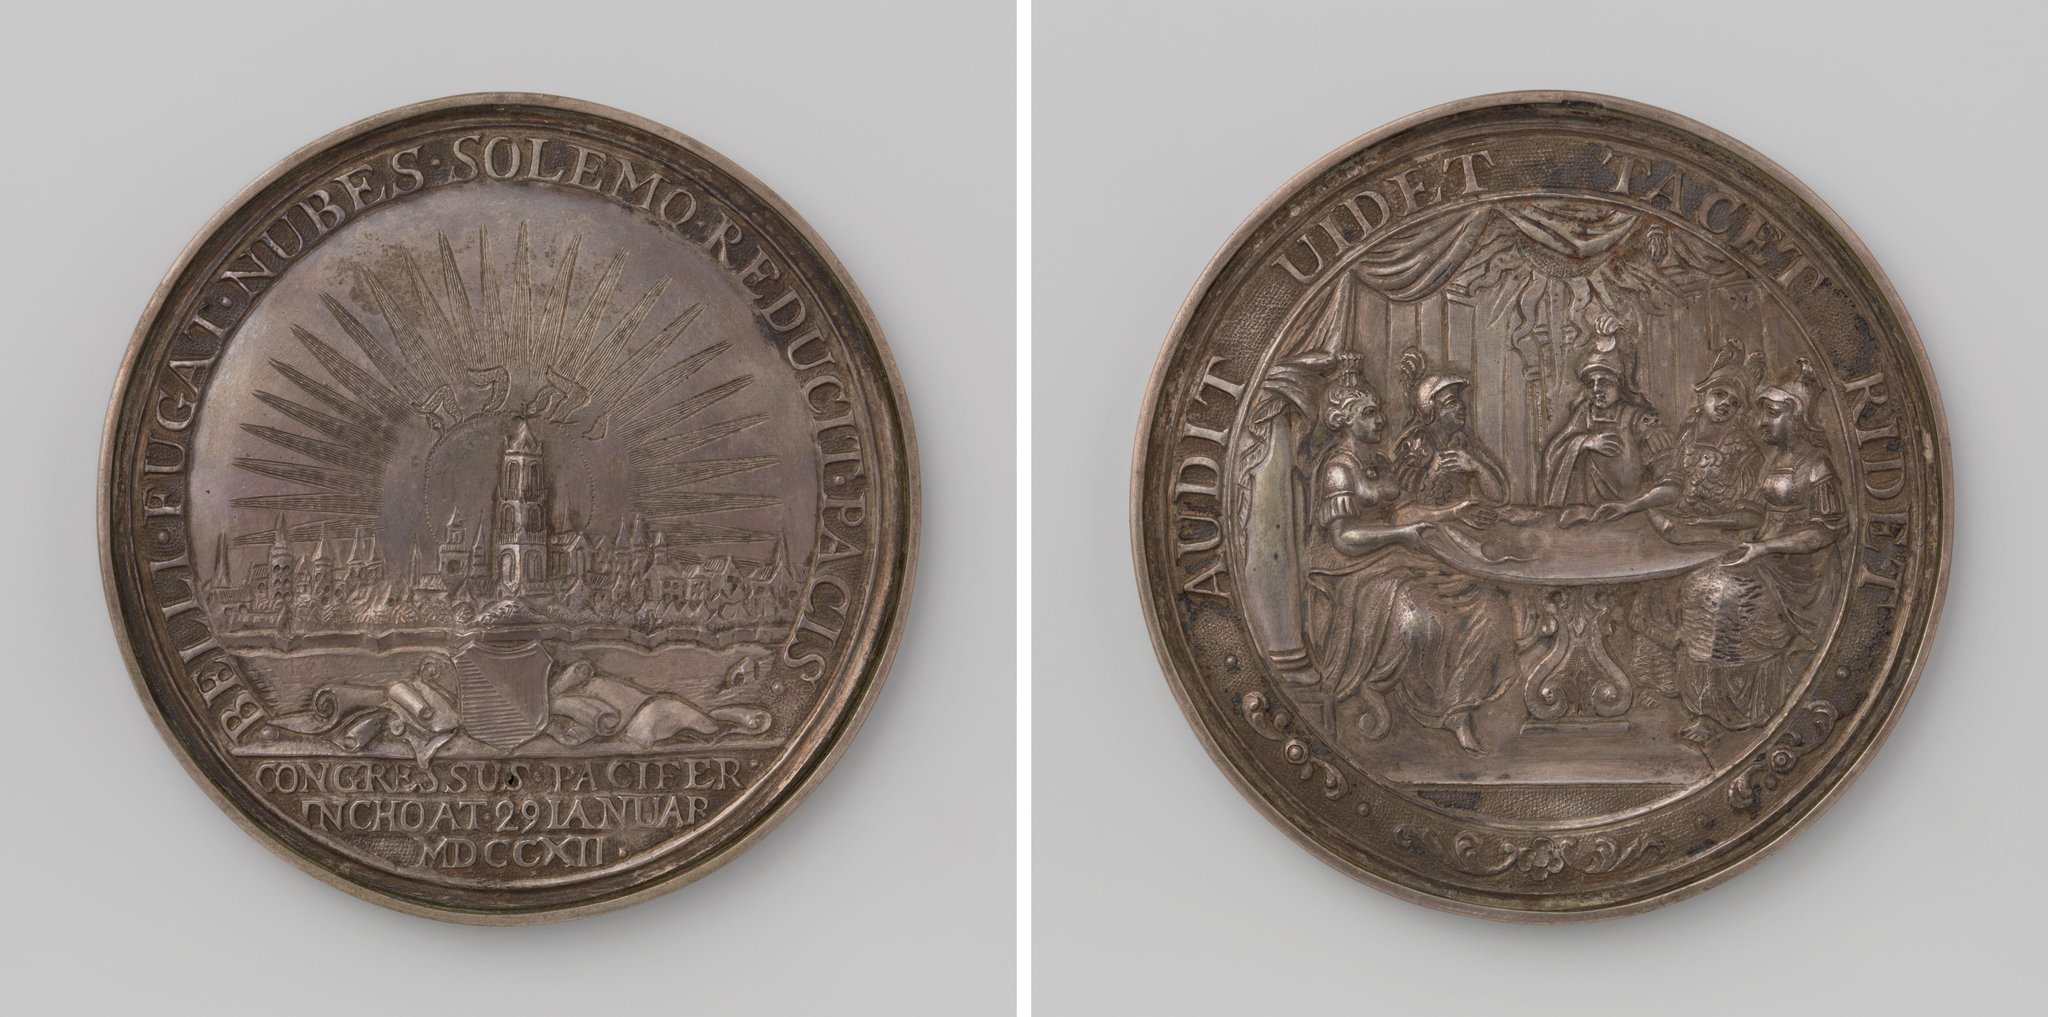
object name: history medal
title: Openen van de vredesonderhandelingen te Utrecht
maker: Anonymous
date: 1712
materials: silver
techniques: casting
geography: netherlands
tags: utrecht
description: Zilveren penning. Voorzijde: gezicht op stad Utrecht binnen stralenkrans boven wapenschild en rollen papier binnen omschrift; afsnede: opschrift. Keerzijde: Frankrijk, Spanje, Groot-Britannie, Duitsland en de Republiek, in de gedaante van vijf vrouwen zittend rondom tafel binnen omschrift.